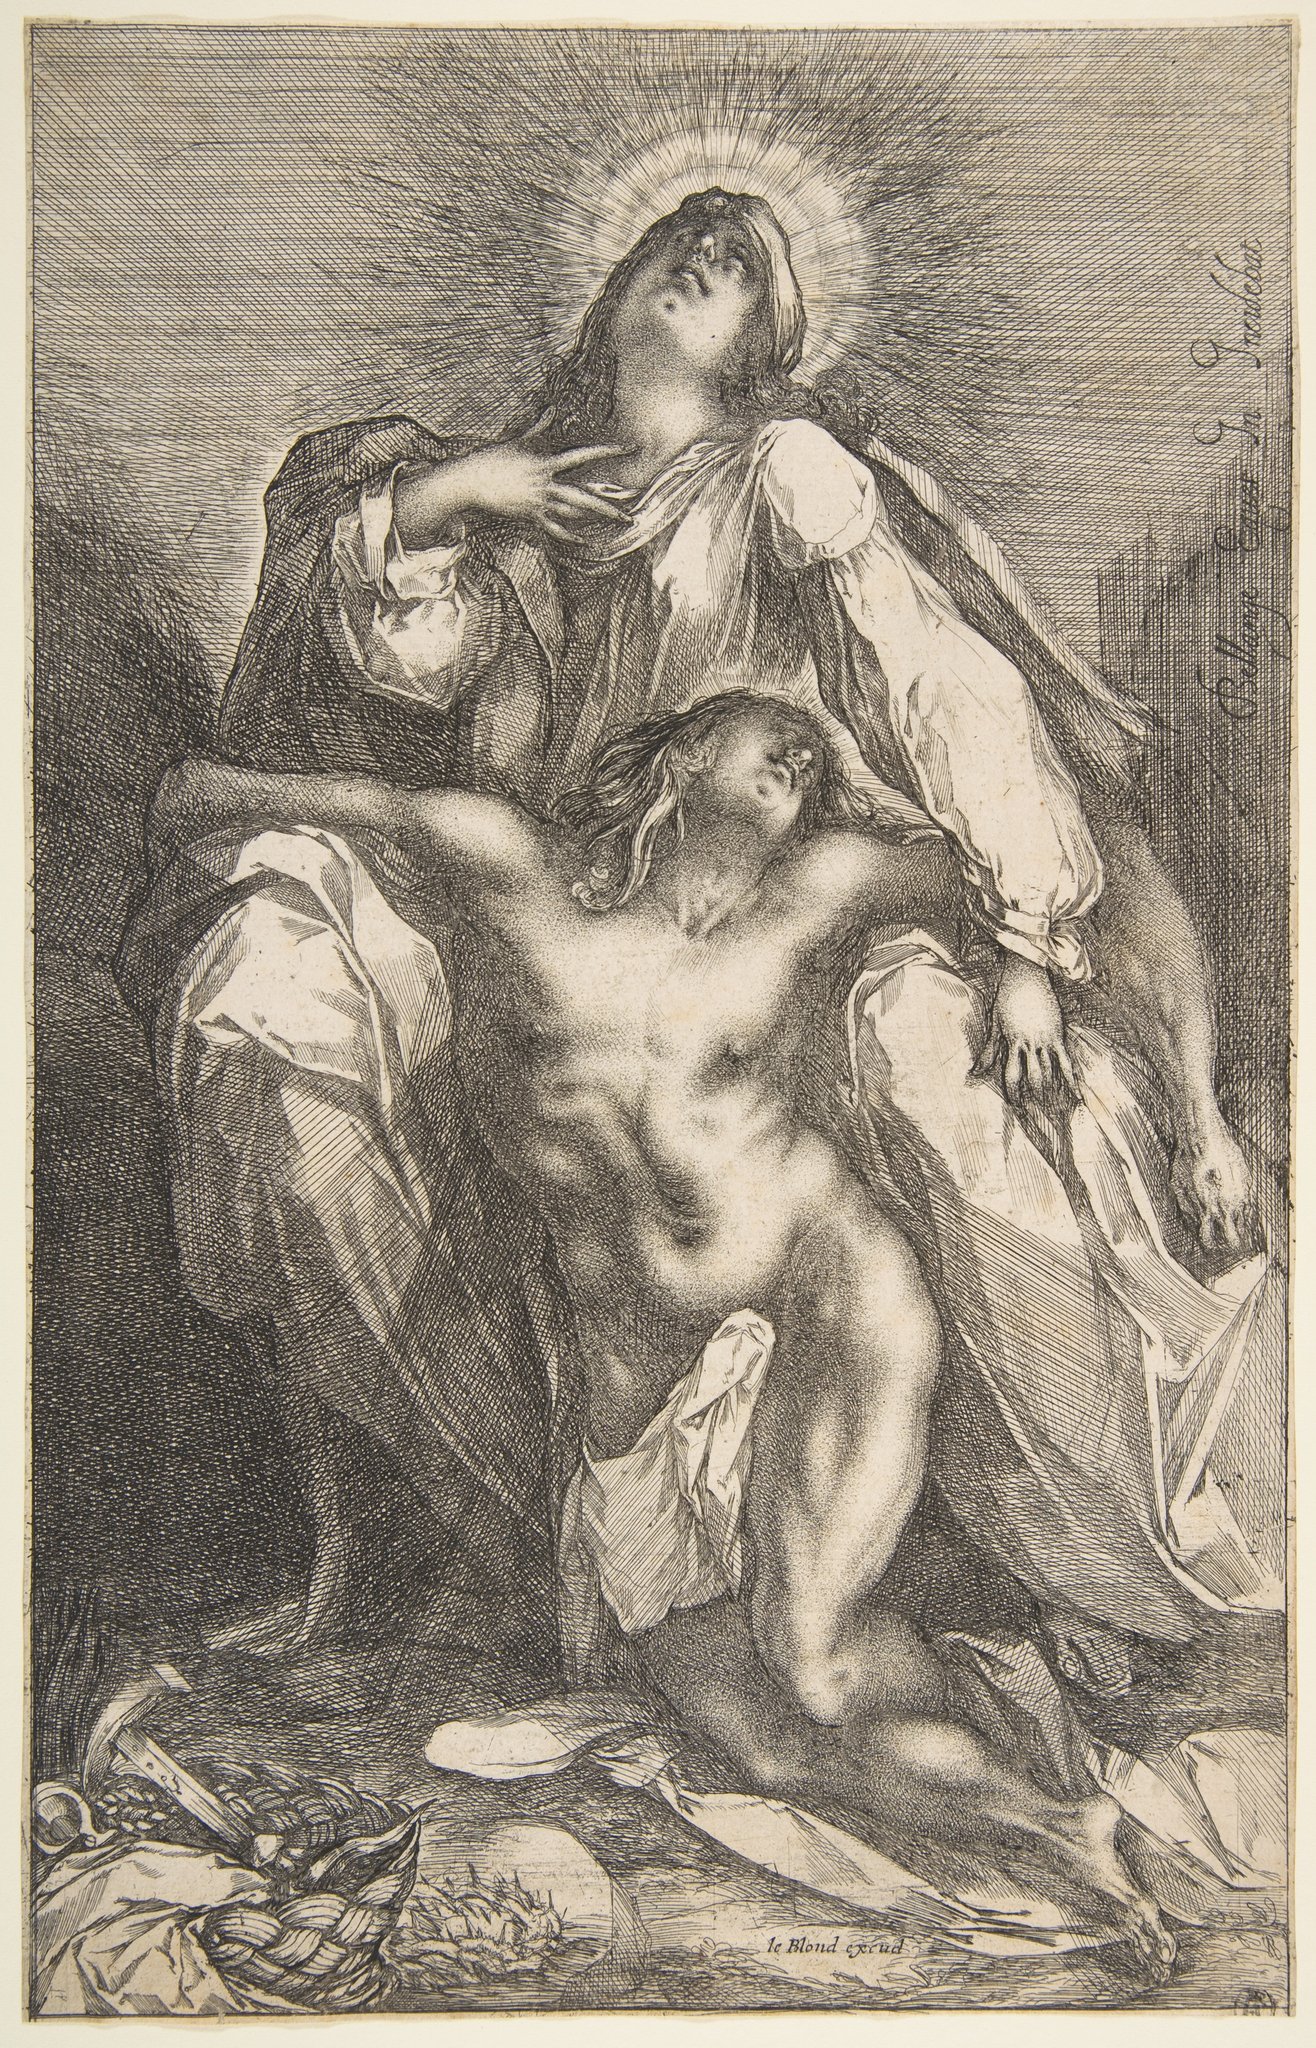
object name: print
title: Pietà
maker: jacques bellange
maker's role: artist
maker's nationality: french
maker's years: 1575-1616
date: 1612-1616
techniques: engraving, etching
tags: virgin mary,jesus